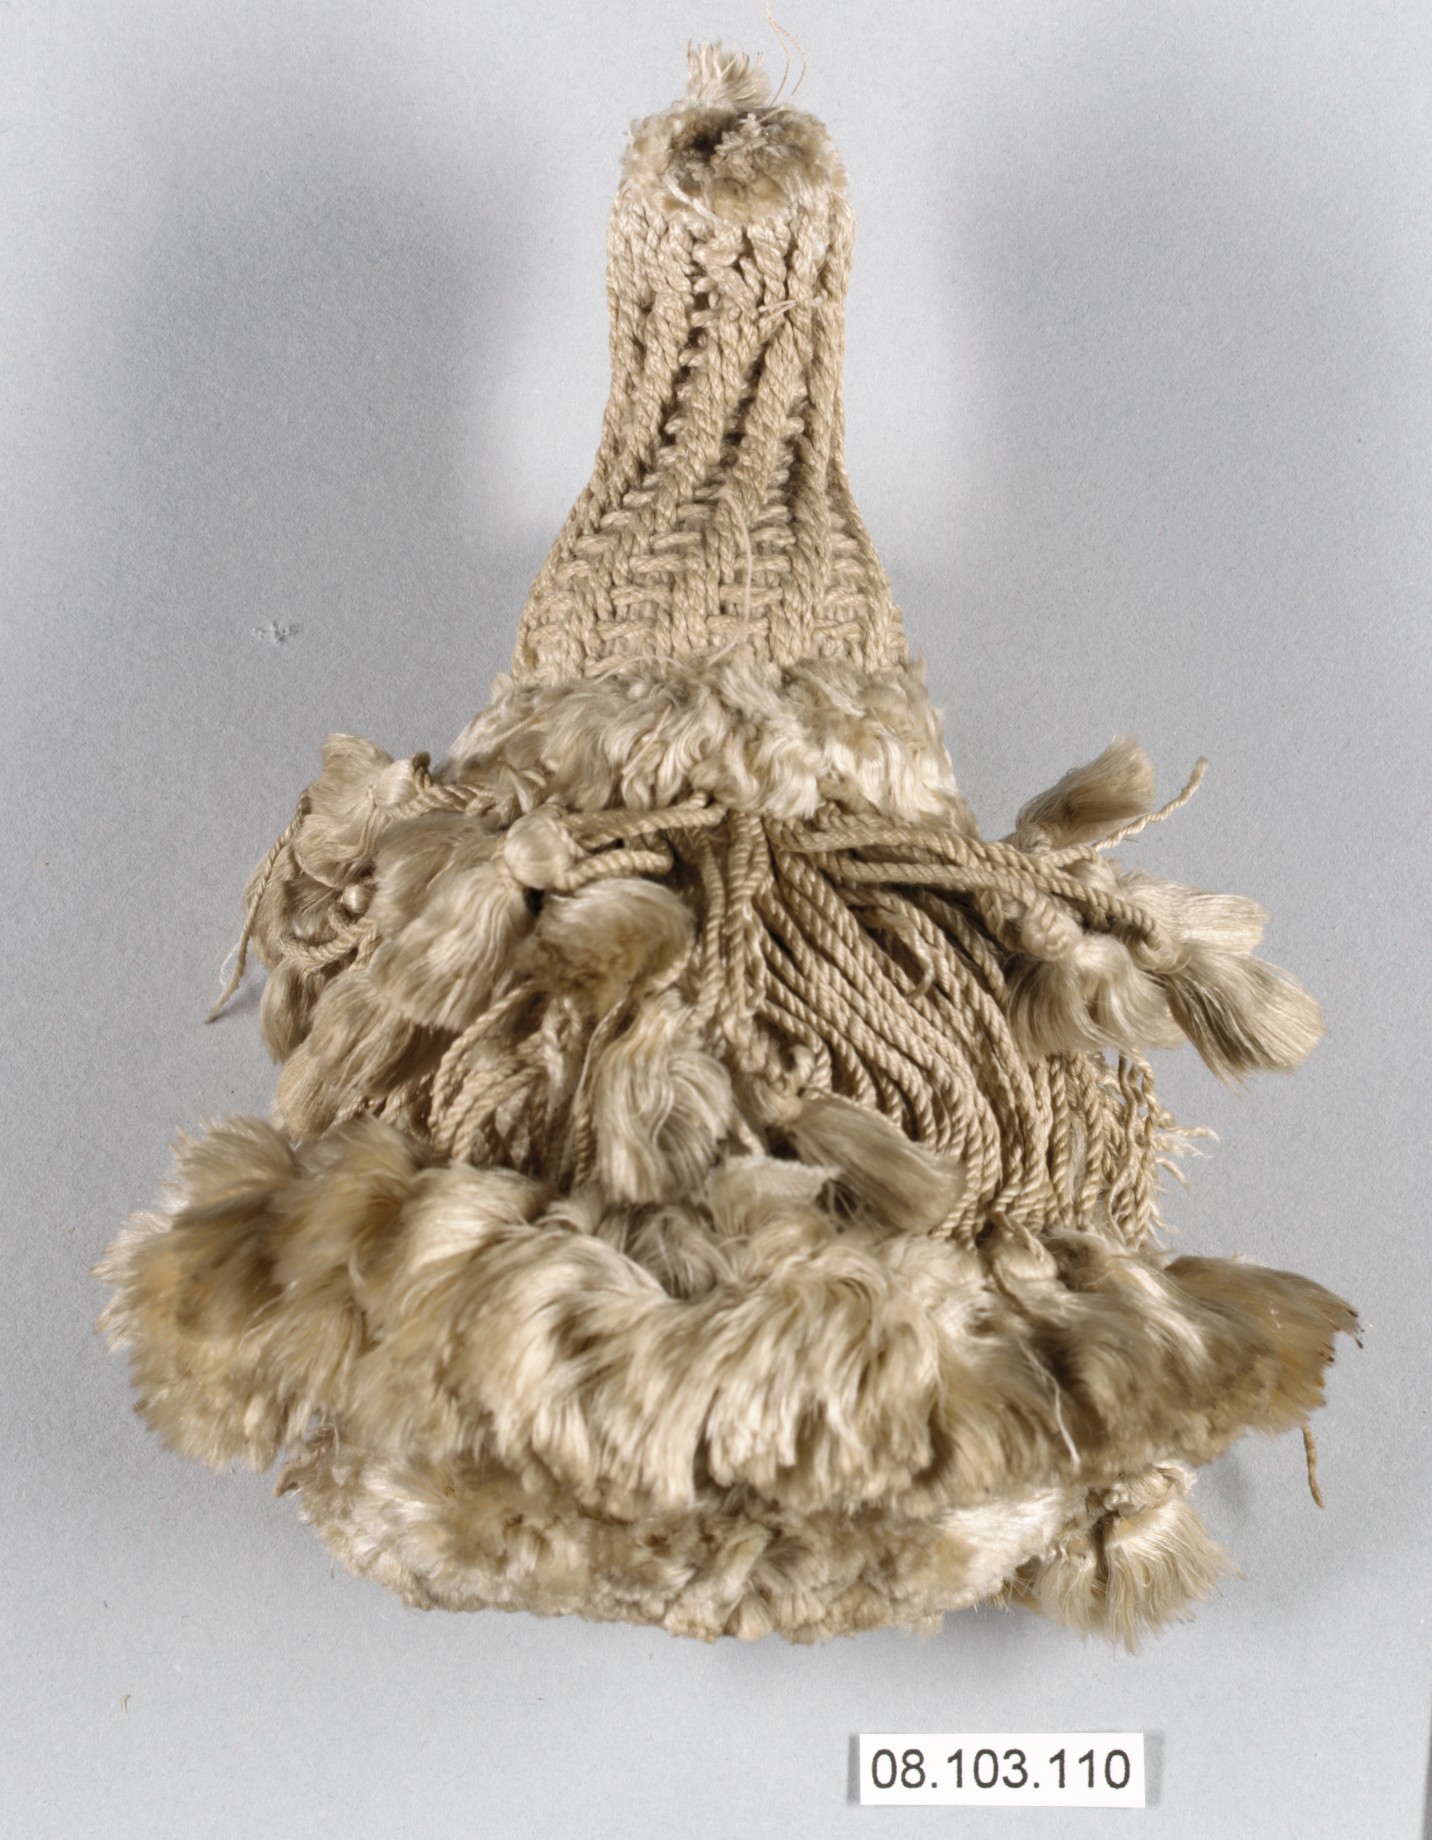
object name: tassel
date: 1567-1633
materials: silk